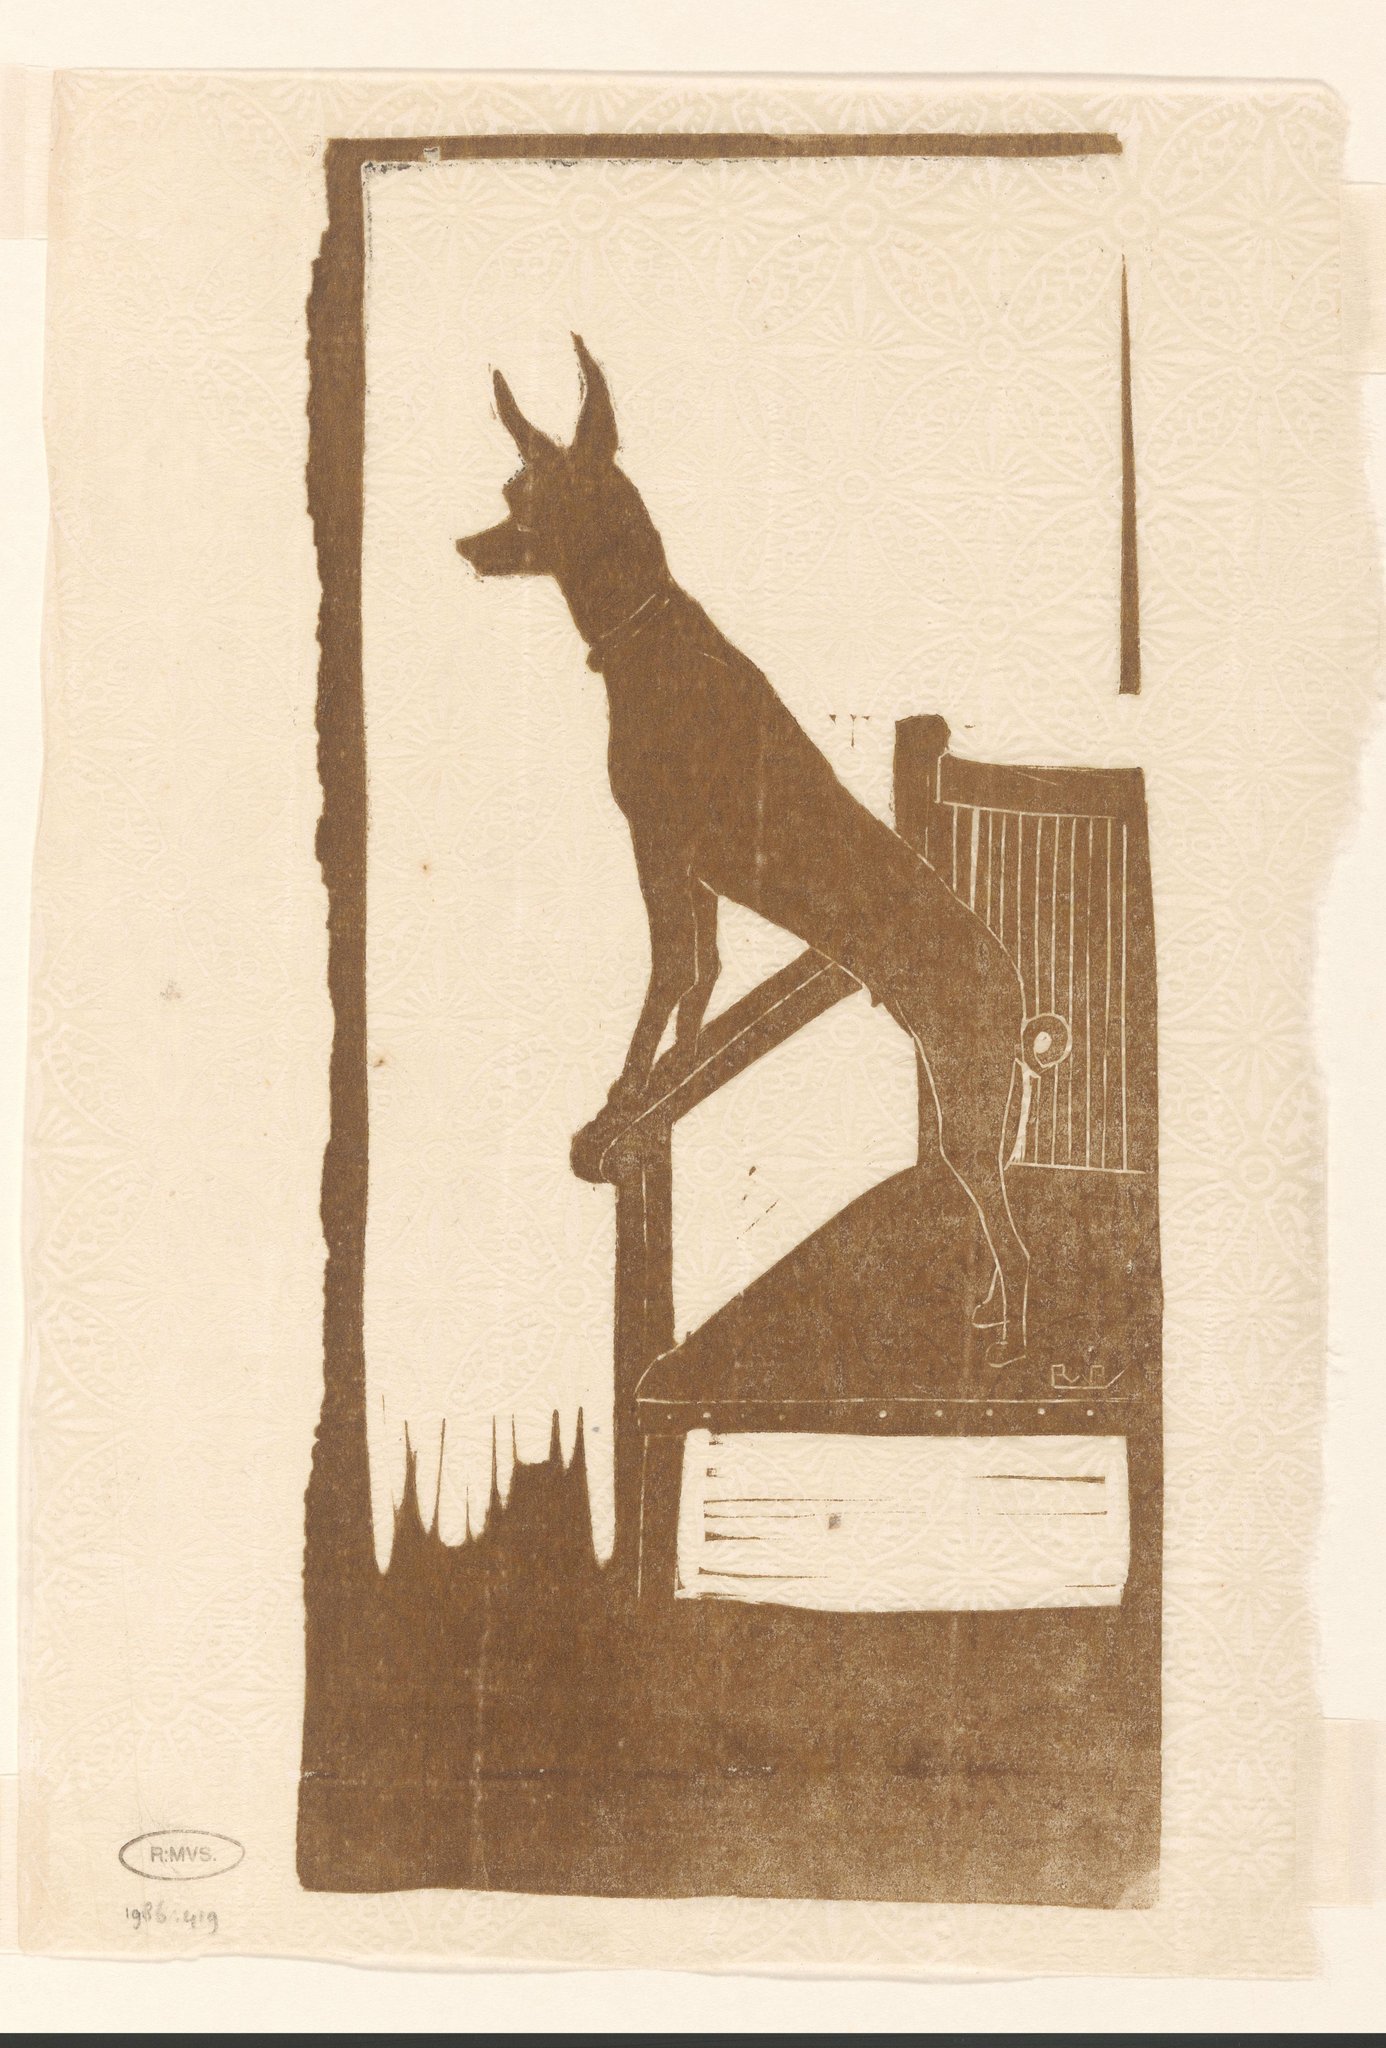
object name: print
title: Hond, staand op een stoel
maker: reinier willem petrus de vries (1874-1953)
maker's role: draughtsman, print maker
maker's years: 1874-1953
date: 1884-1952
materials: paper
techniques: linocut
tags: chair, dog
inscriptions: collector's mark: Lugt 2228